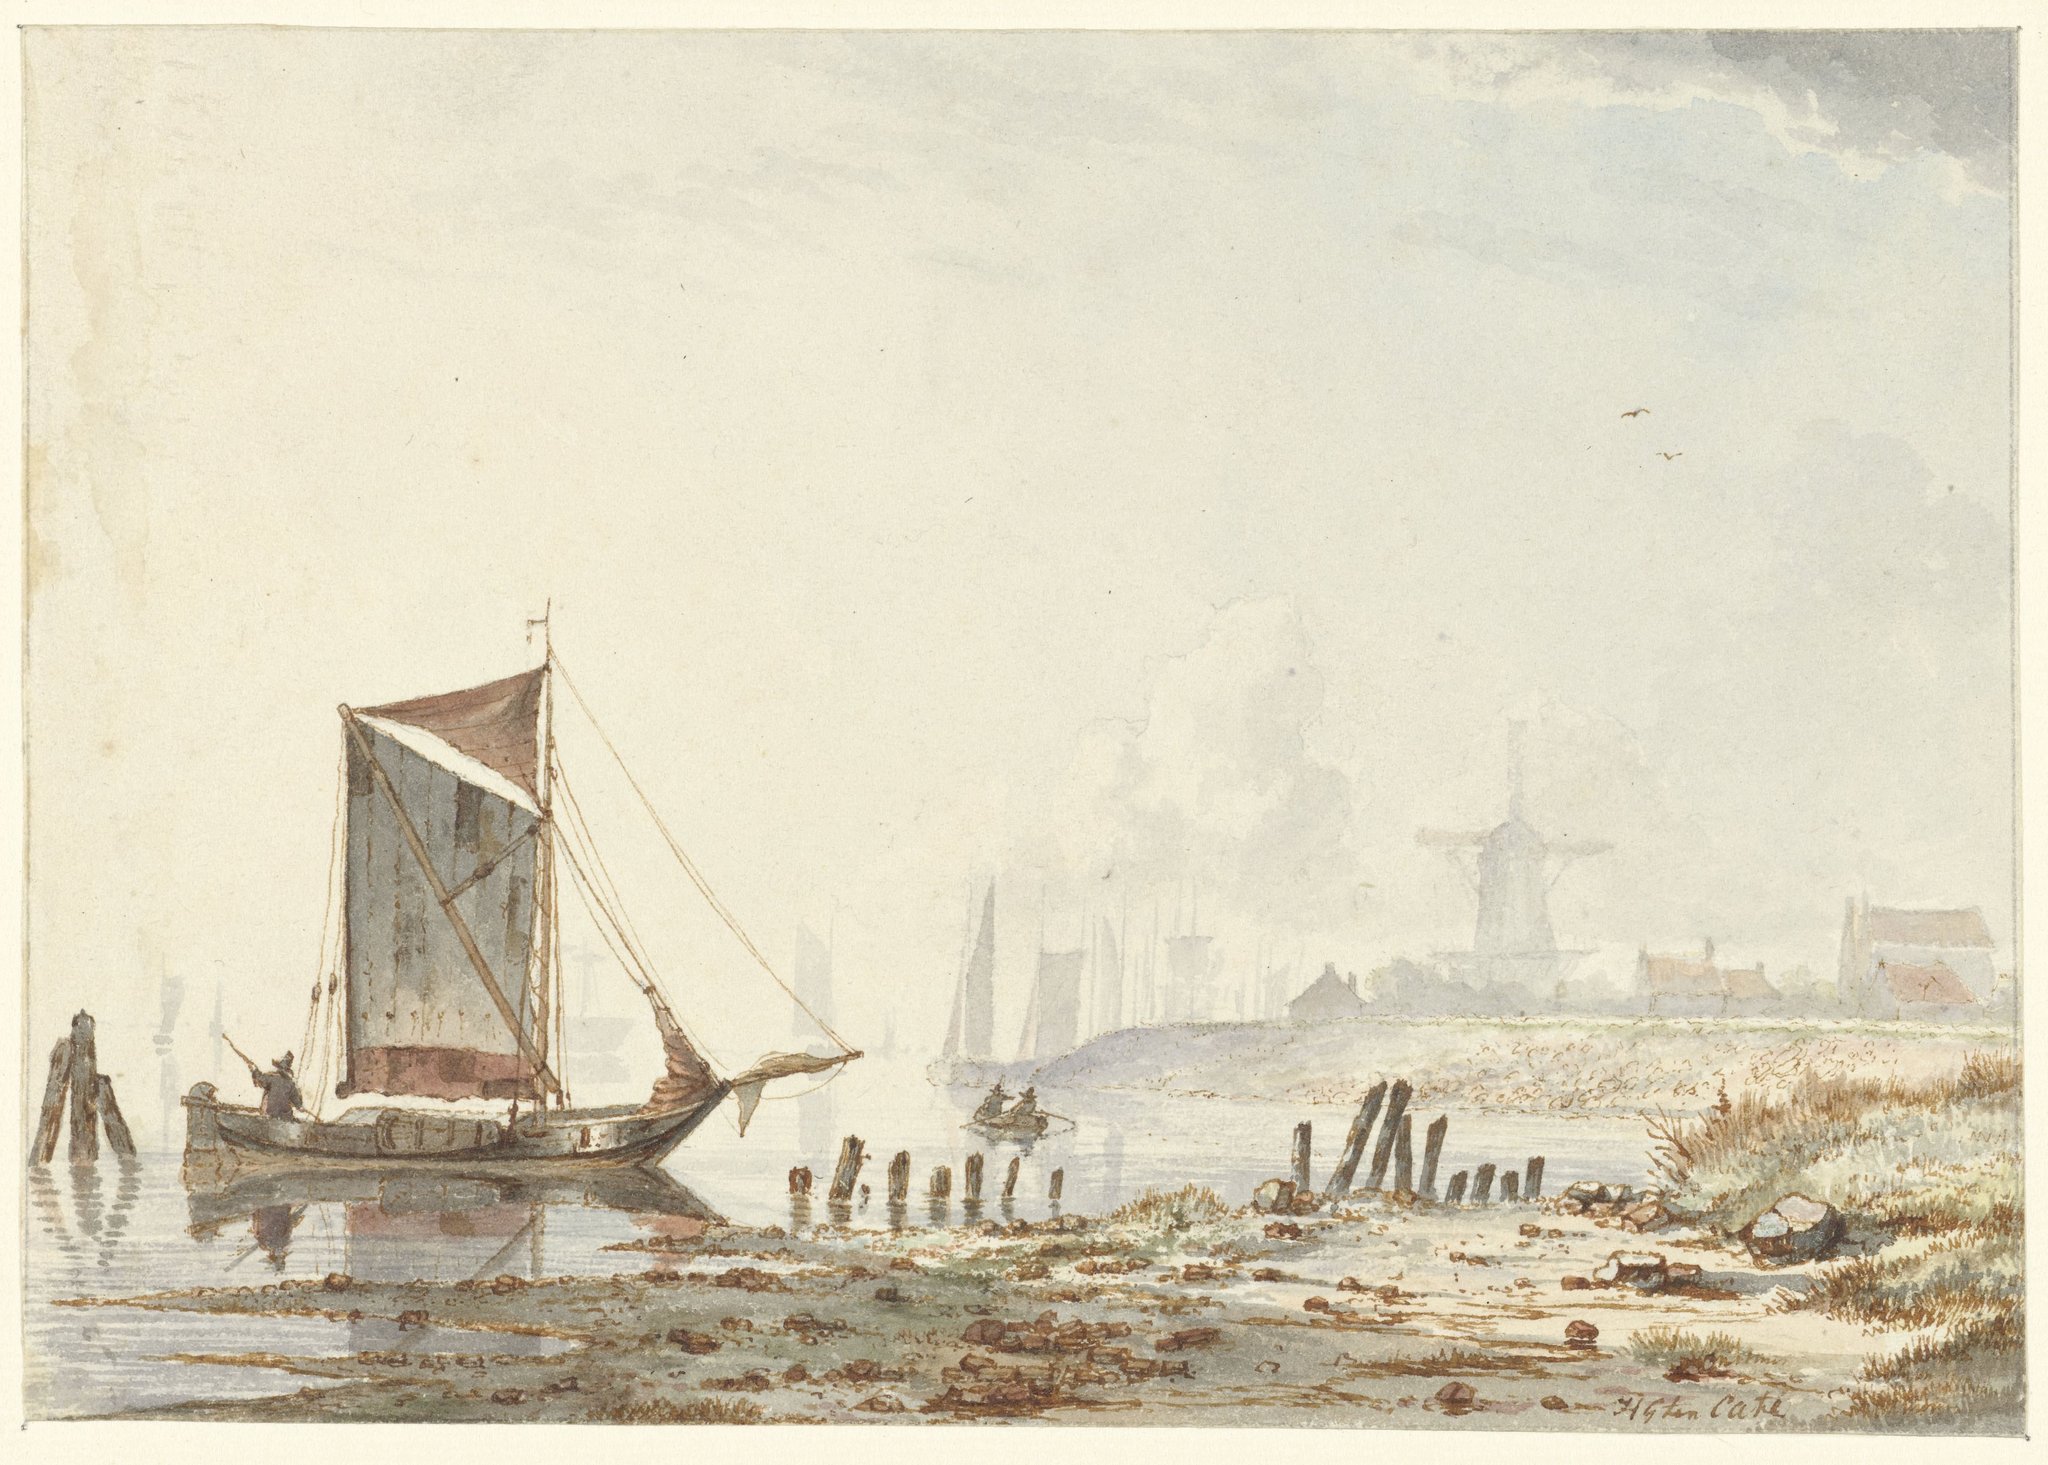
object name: drawing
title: Schepen op een rivier, bij de oever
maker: hendrik gerrit ten cate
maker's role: draughtsman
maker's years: 1803-1856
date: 1813-1856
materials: ink, paper, watercolor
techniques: brush, pen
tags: sailing-ship, sailing-boat, river